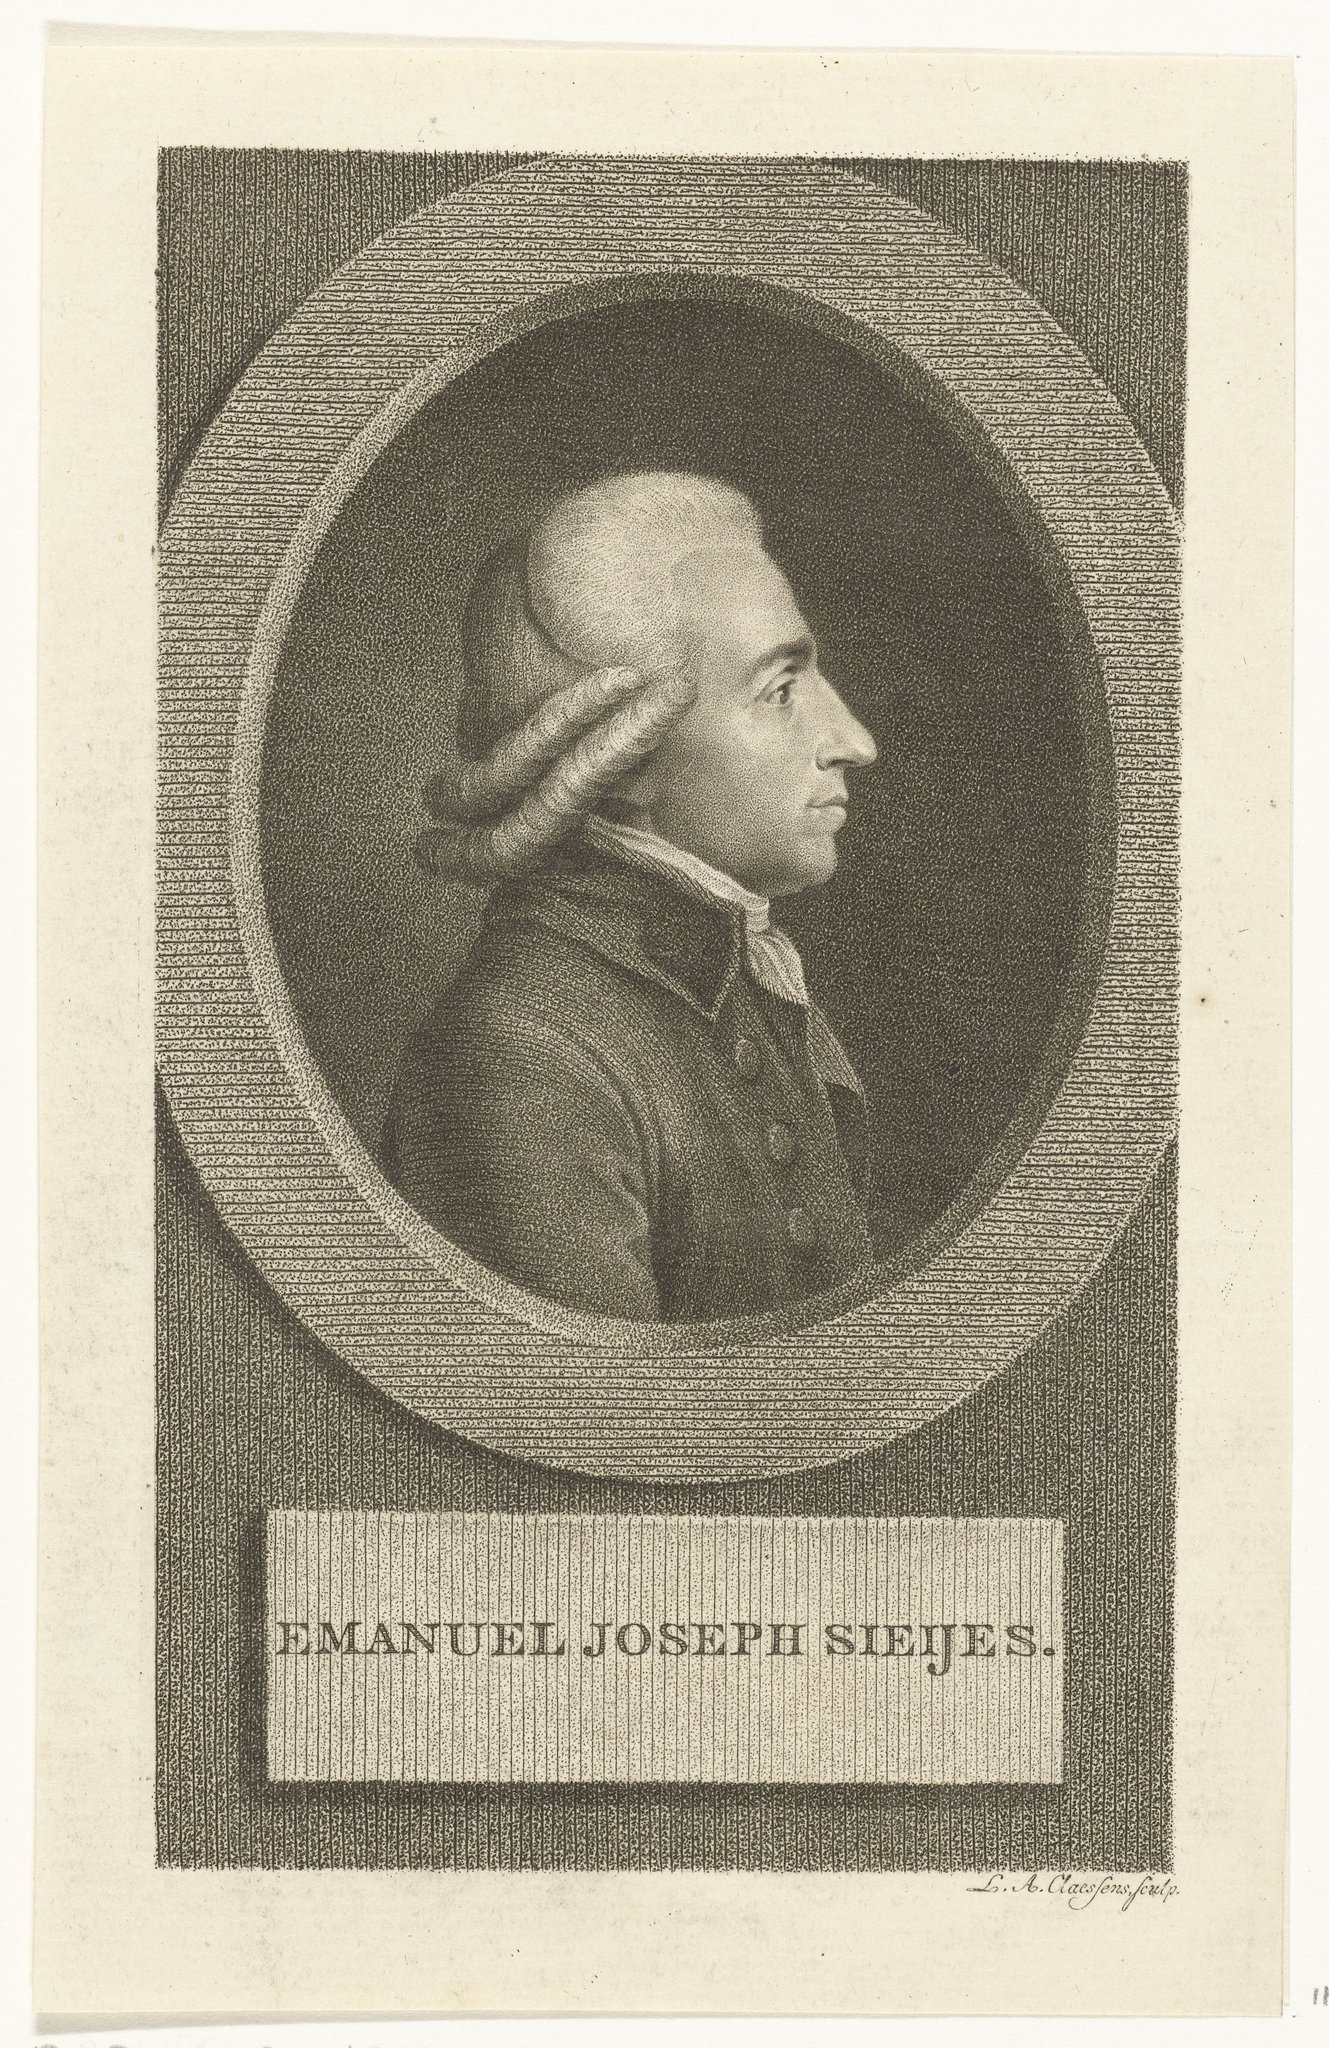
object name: print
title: Portret van Emmanuel Joseph Sieyès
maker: lambertus antonius claessens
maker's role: draughtsman, print maker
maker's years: 1763-1834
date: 1792-1808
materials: paper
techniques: engraving, etching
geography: amsterdam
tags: politician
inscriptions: collector's mark: Lugt 2228